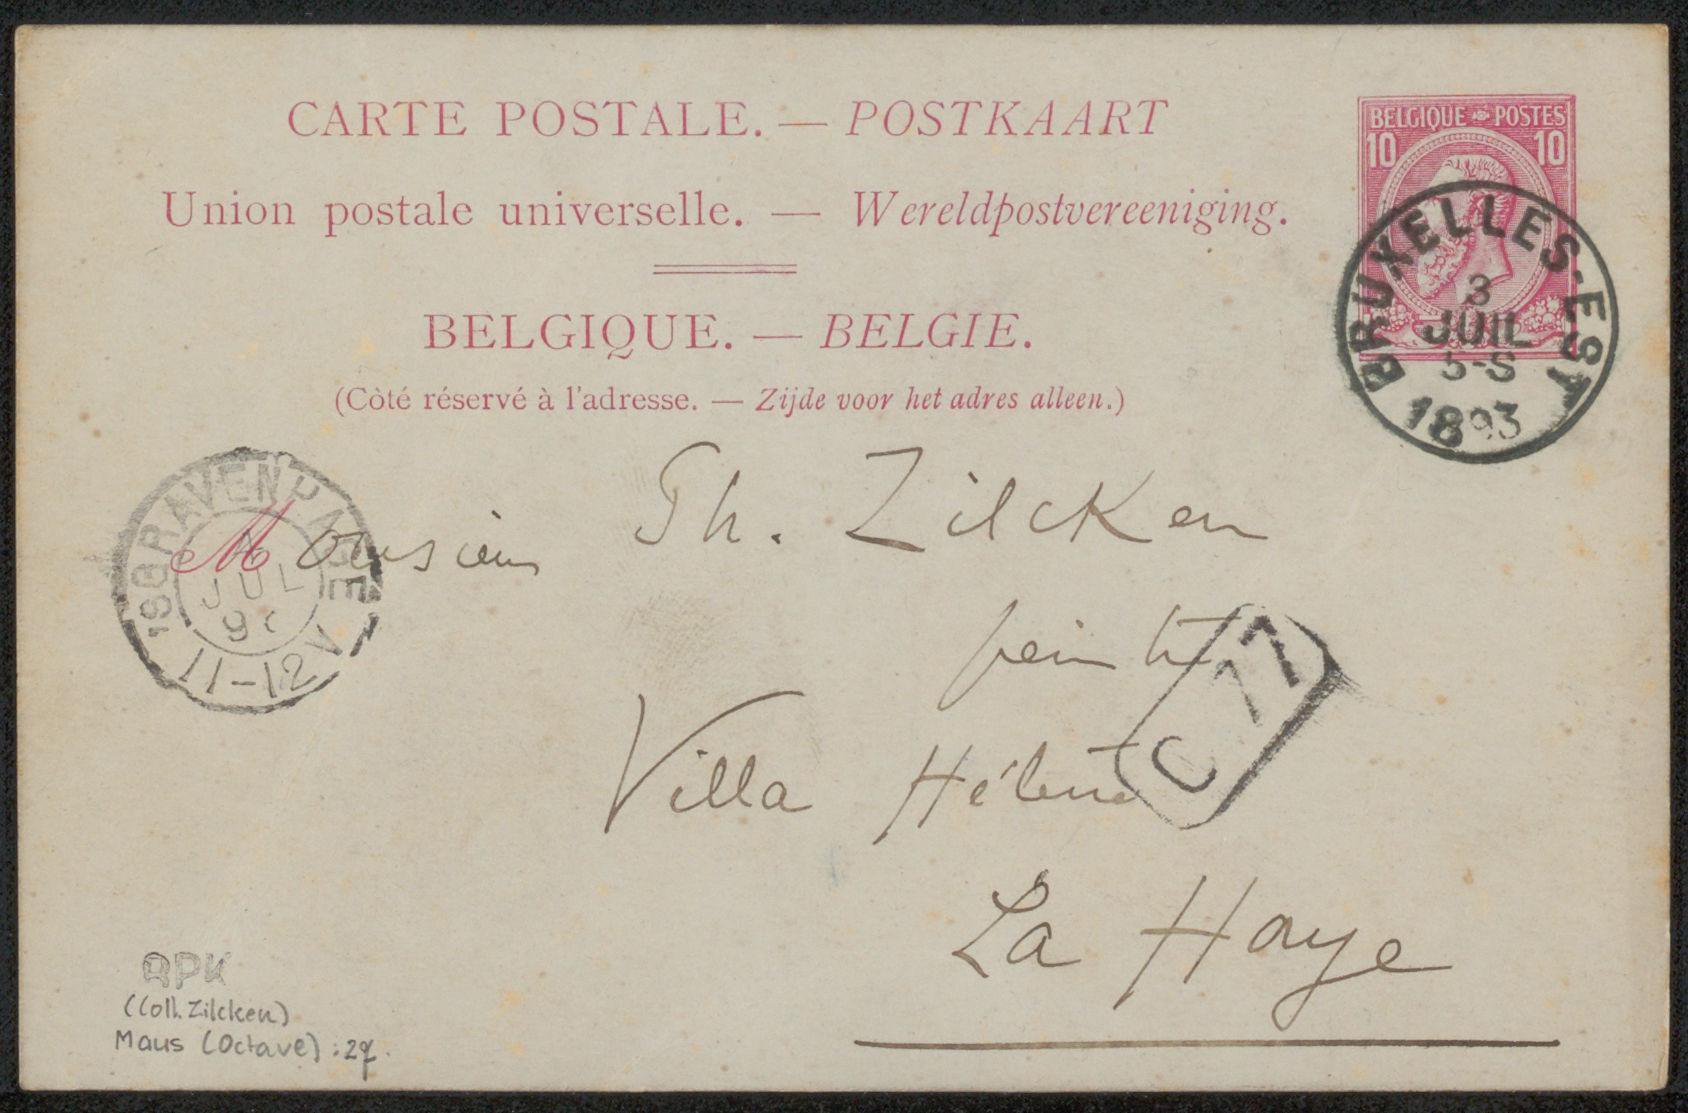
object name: postcard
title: Briefkaart aan Philip Zilcken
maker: octave maus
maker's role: painter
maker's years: 1856-1919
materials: cardboard, ink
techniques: pen, writing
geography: brussels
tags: paris, paul verlaine, print maker, félicien rops, the hague, painter, draughtsman, philip zilcken, historical persons (portraits and scenes from the life)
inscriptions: collector's mark: ‘RPK’